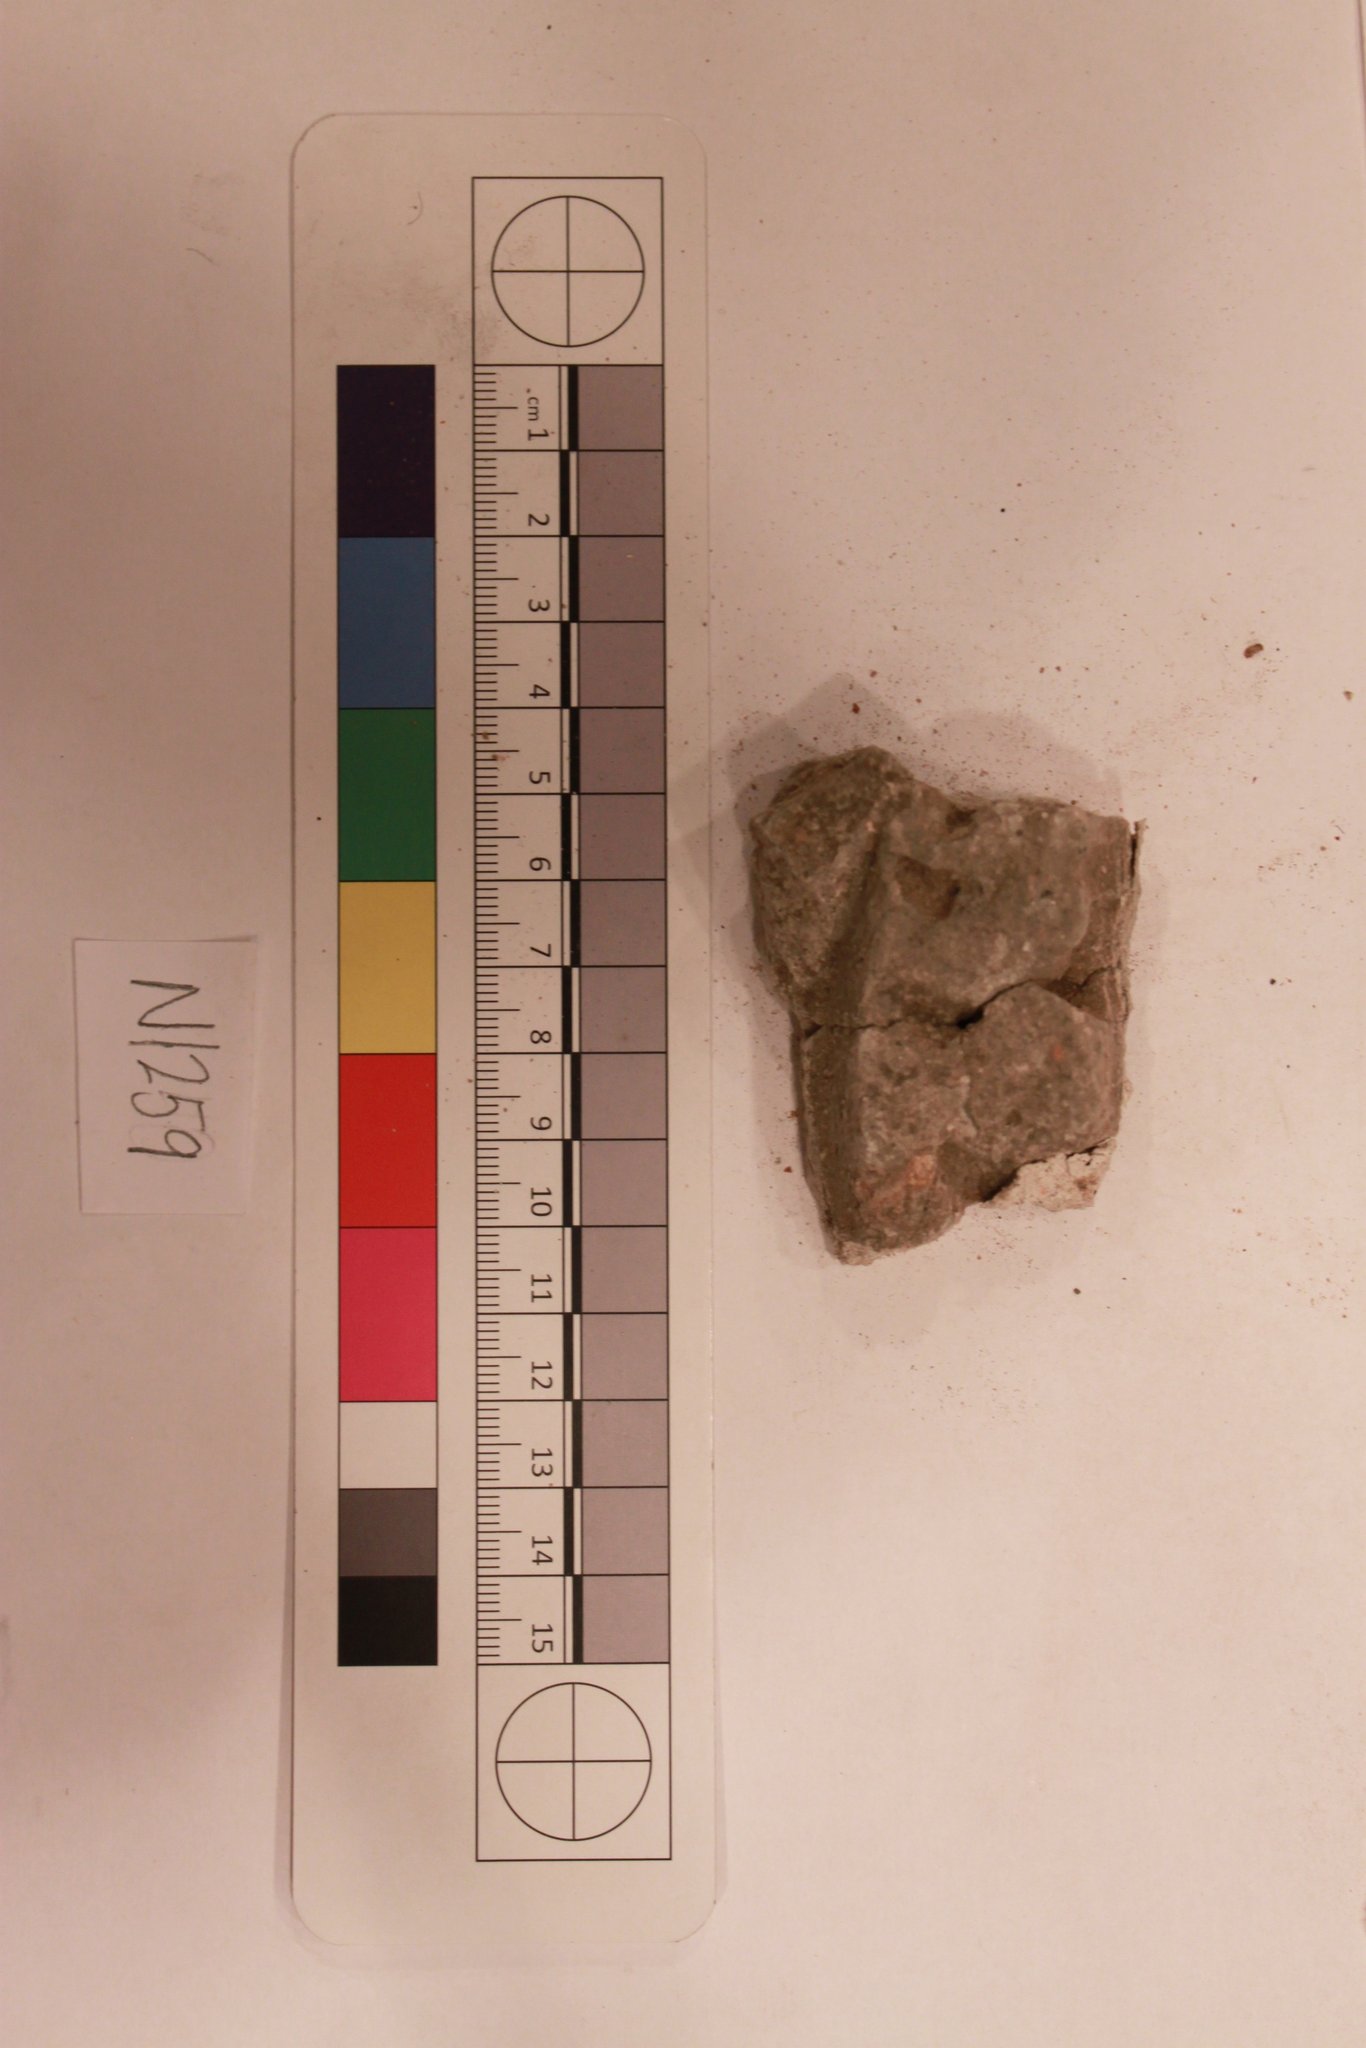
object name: fragment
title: Stucco Fragment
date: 701-1200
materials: plaster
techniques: carving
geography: iran